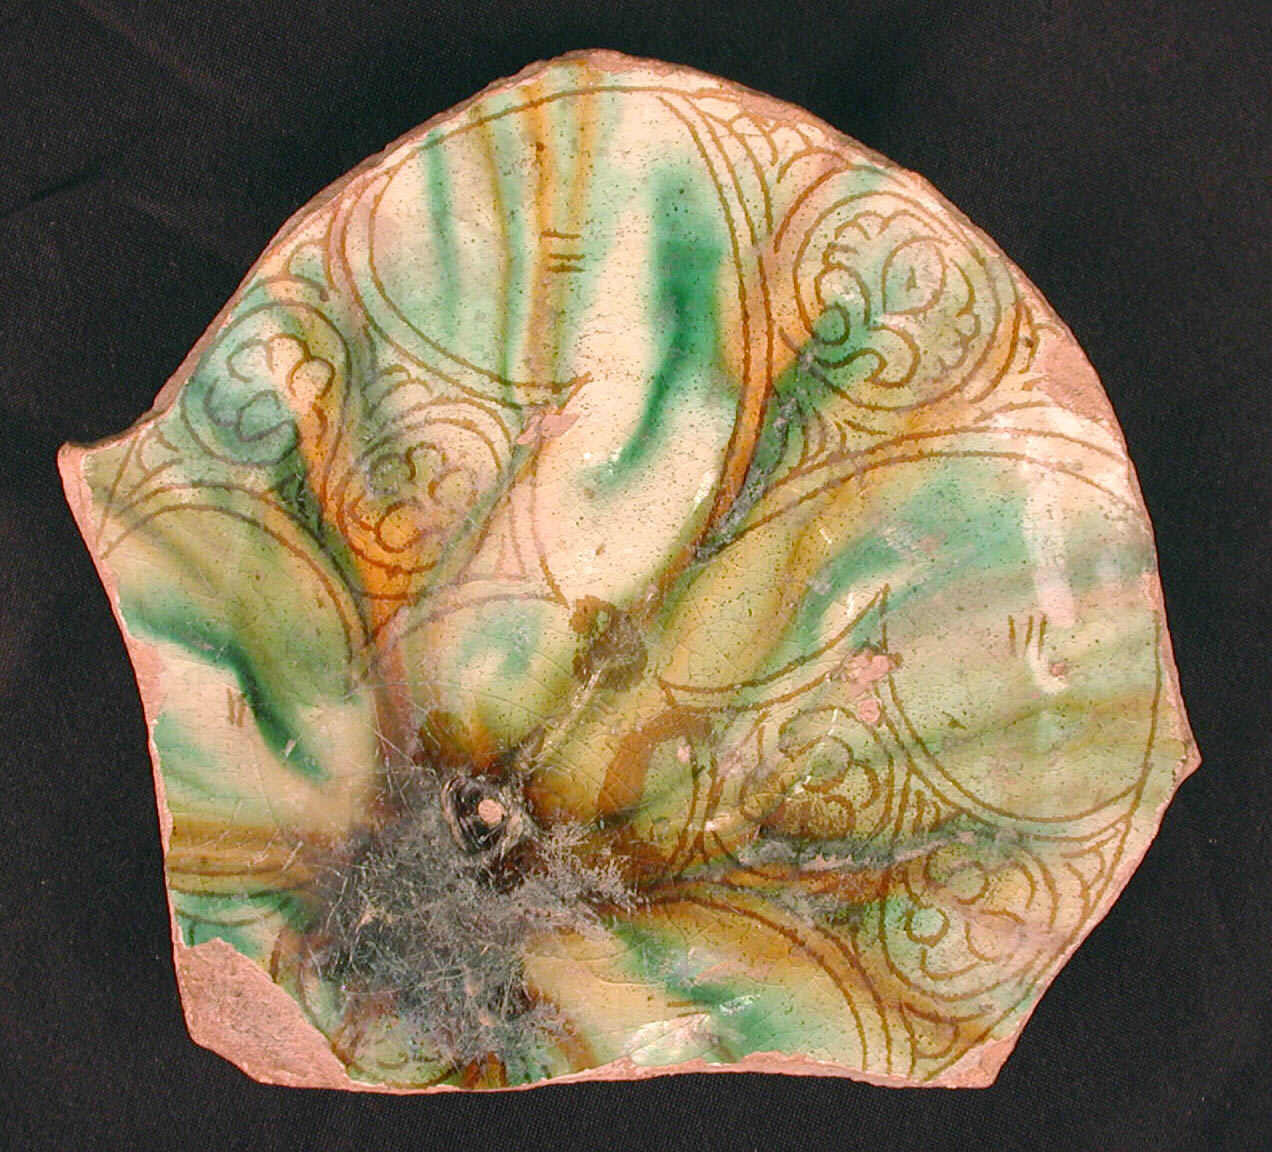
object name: fragment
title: Ceramic Fragment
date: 801-1000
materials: earthenware, glaze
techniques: incising, polychrome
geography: iran